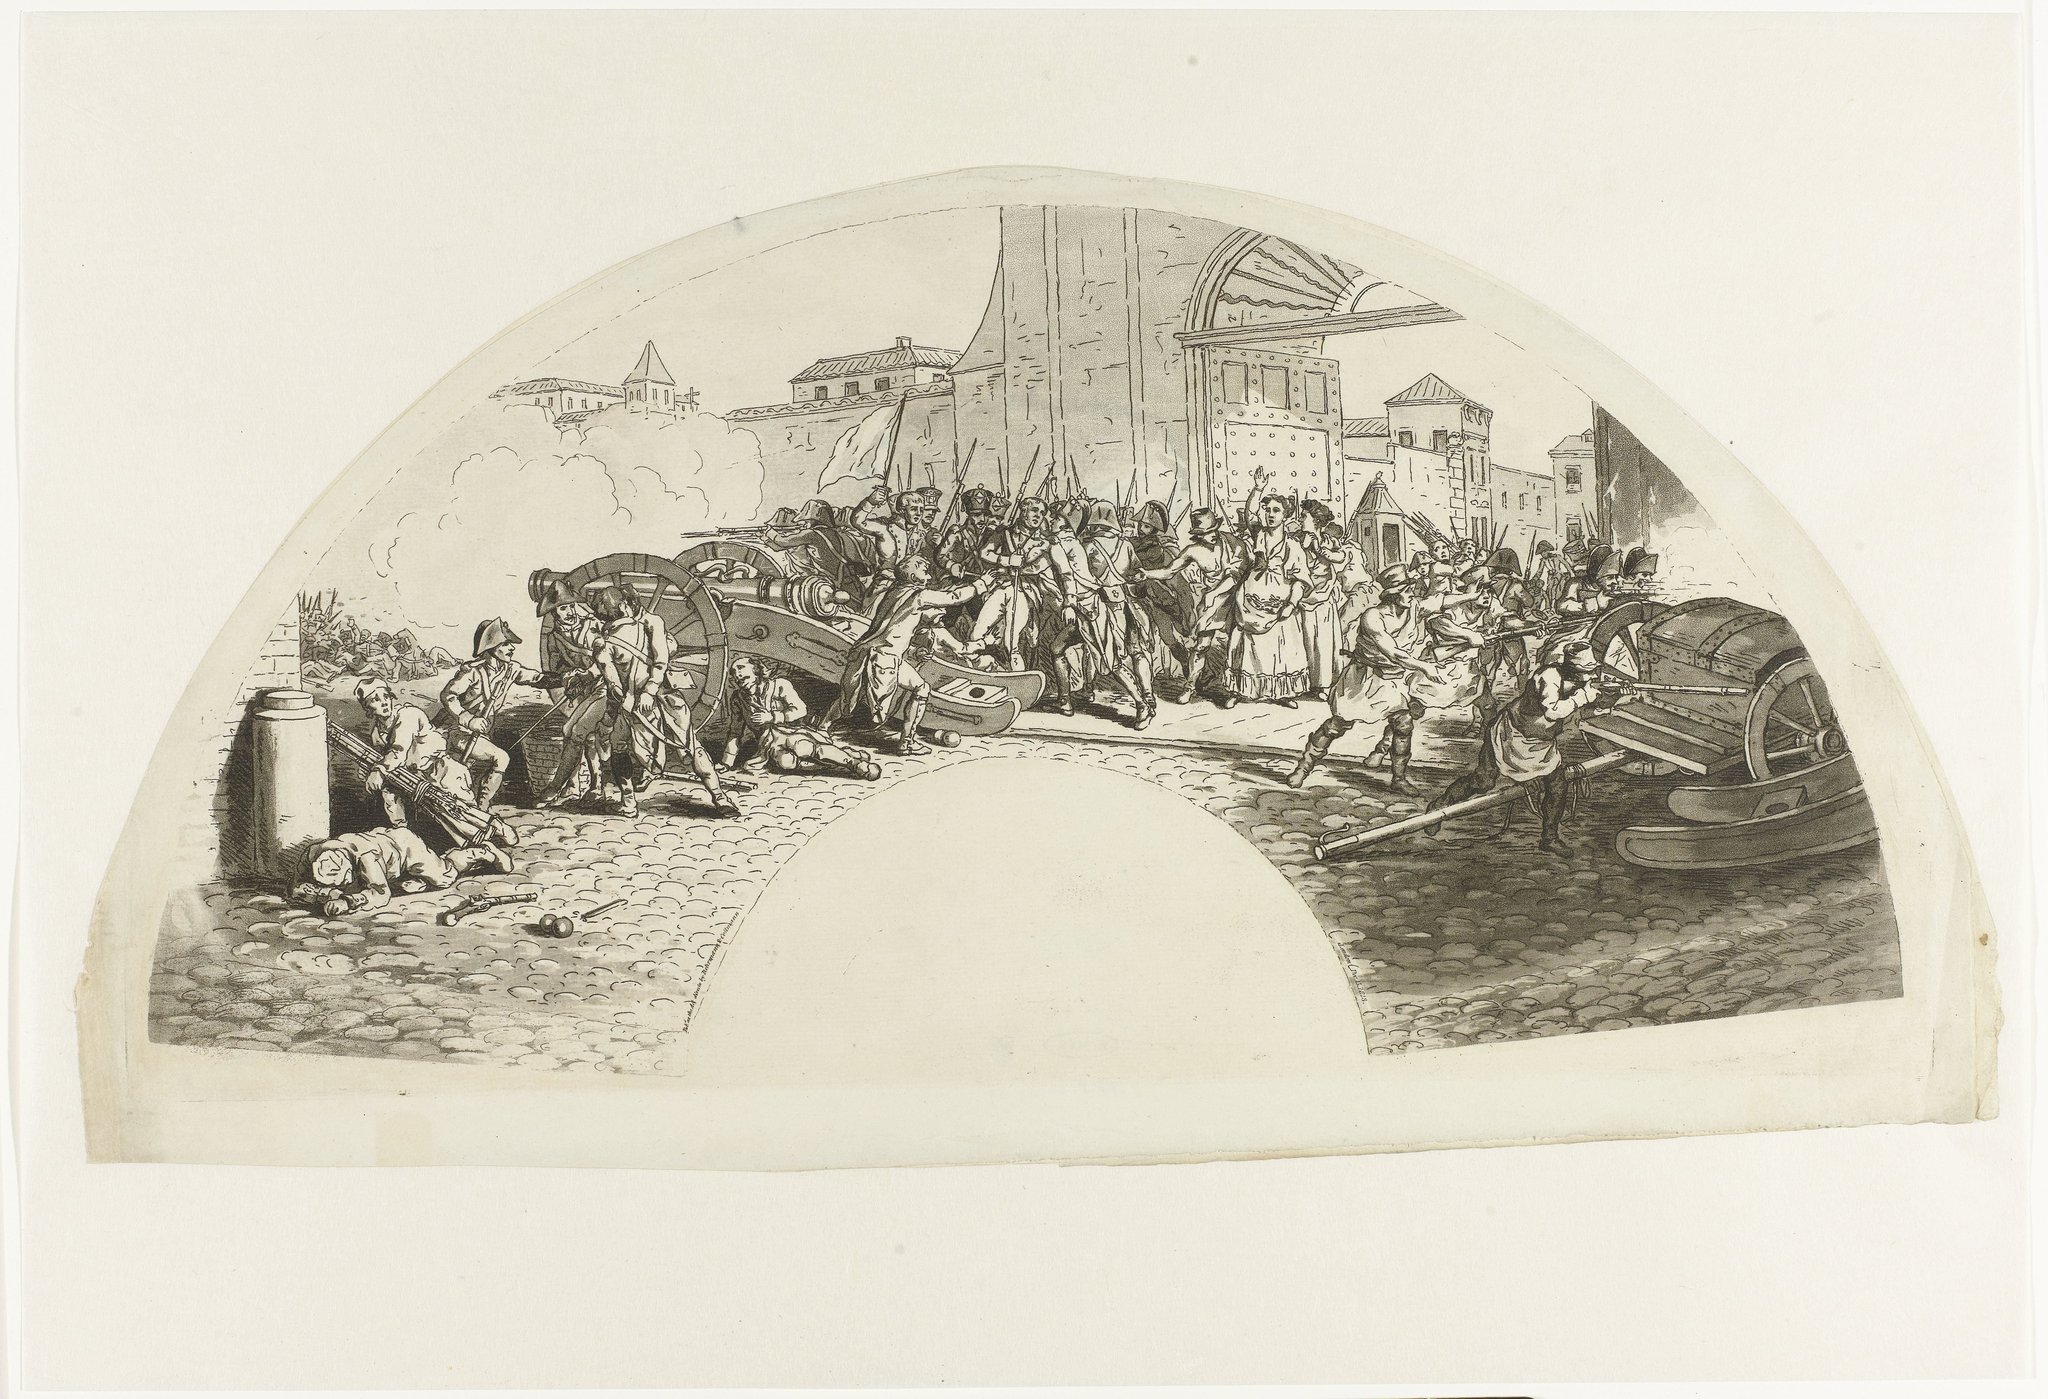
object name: print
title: Dood van de Spaanse patriotten Luis Daoiz en Pedro Velarde y Santillán bij de verdediging van Madrid tegen de Franse troepen in het Parque de Artilleria op 2 mei 1808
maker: Anonymous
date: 1813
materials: paper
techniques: aquatint, etching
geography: london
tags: street-fights, riots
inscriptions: title: ‘DIA DOS DE MAYO DE 1808. EN MADRID/ Mueren Daviz y Velarde defendiendo el Parque de Artilleria’, collector's mark: Lugt 2760, collector's mark: Lugt 2228